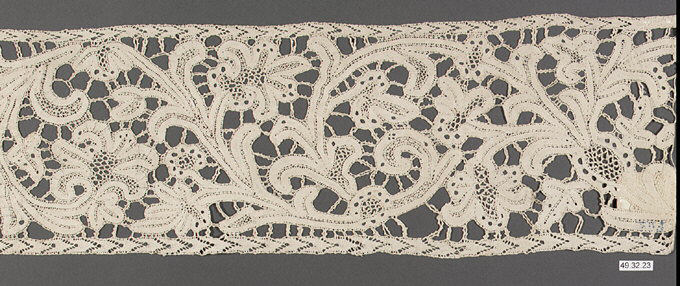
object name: border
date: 1601-1700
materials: lace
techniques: lace